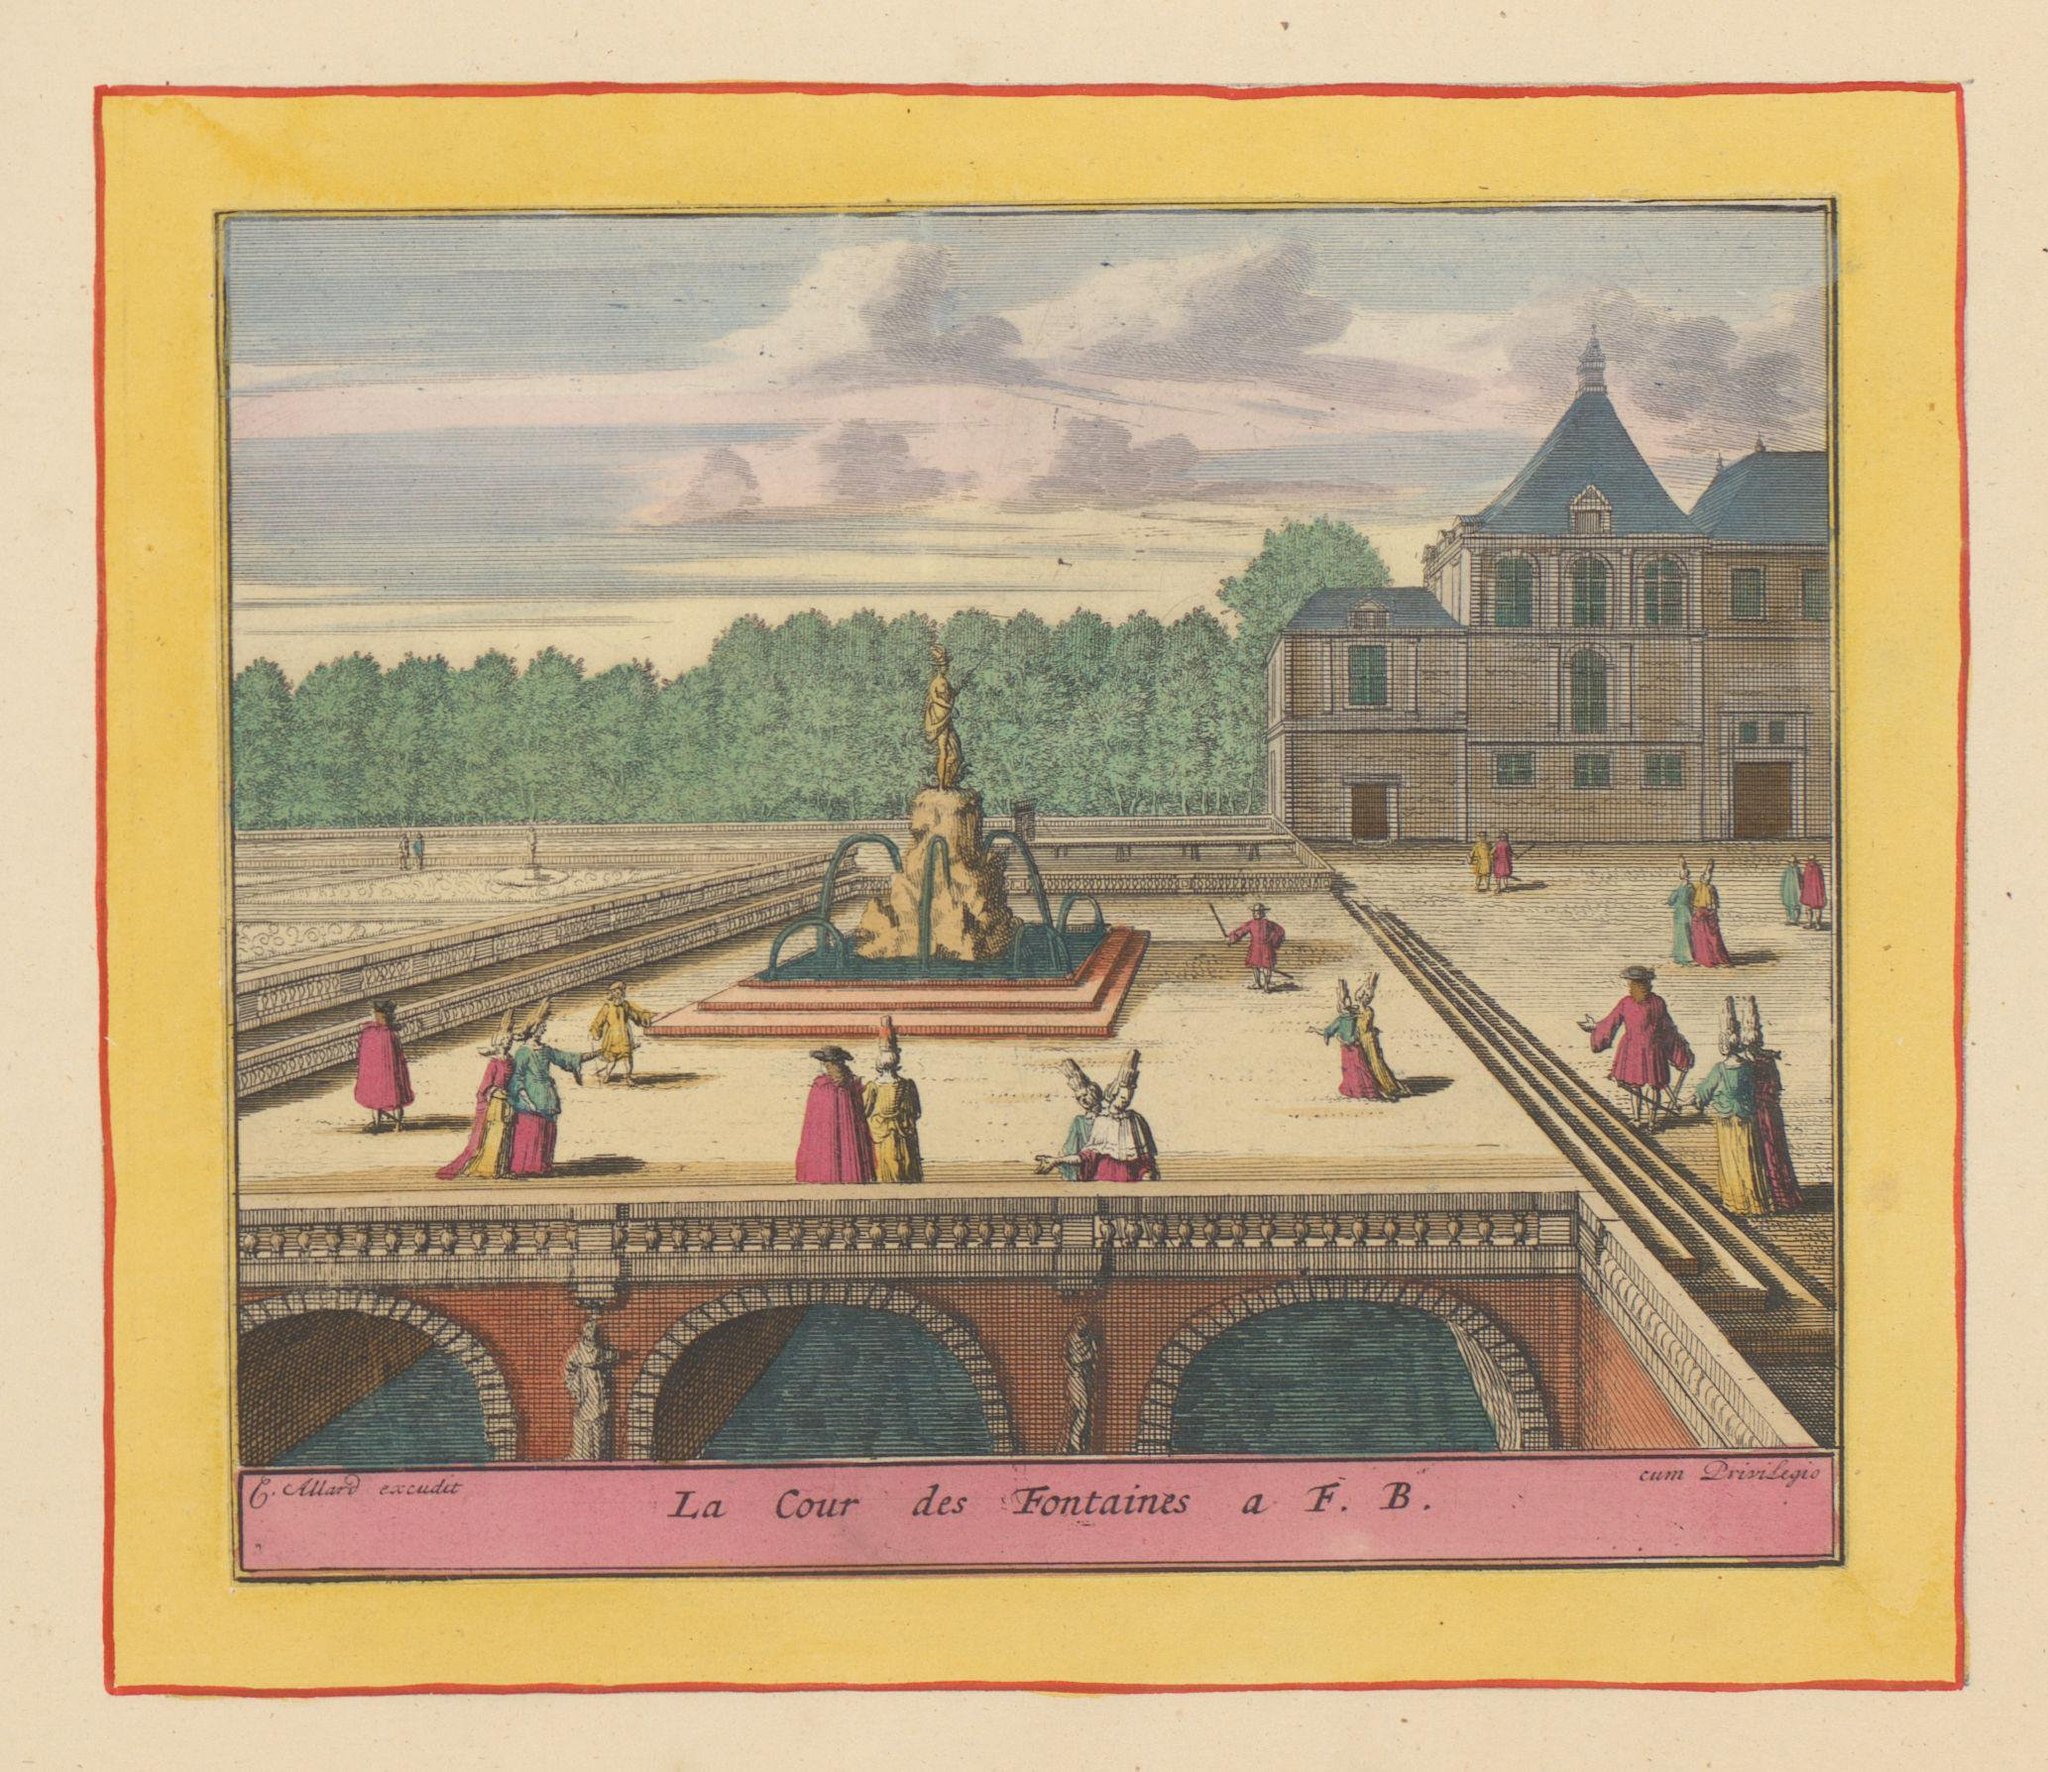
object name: print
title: Gezicht op de Cour de la Fontaine van het paleis van Fontainebleau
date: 1684-1709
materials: paper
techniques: etching, hand coloring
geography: amsterdam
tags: garden fountain, palace, french or architectonic garden; formal garden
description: De Cour de la Fontaine in de tuin van het paleis van Fontainebleau, met wandelende figuren rond een fontein. Prent maakt deel uit van een album.